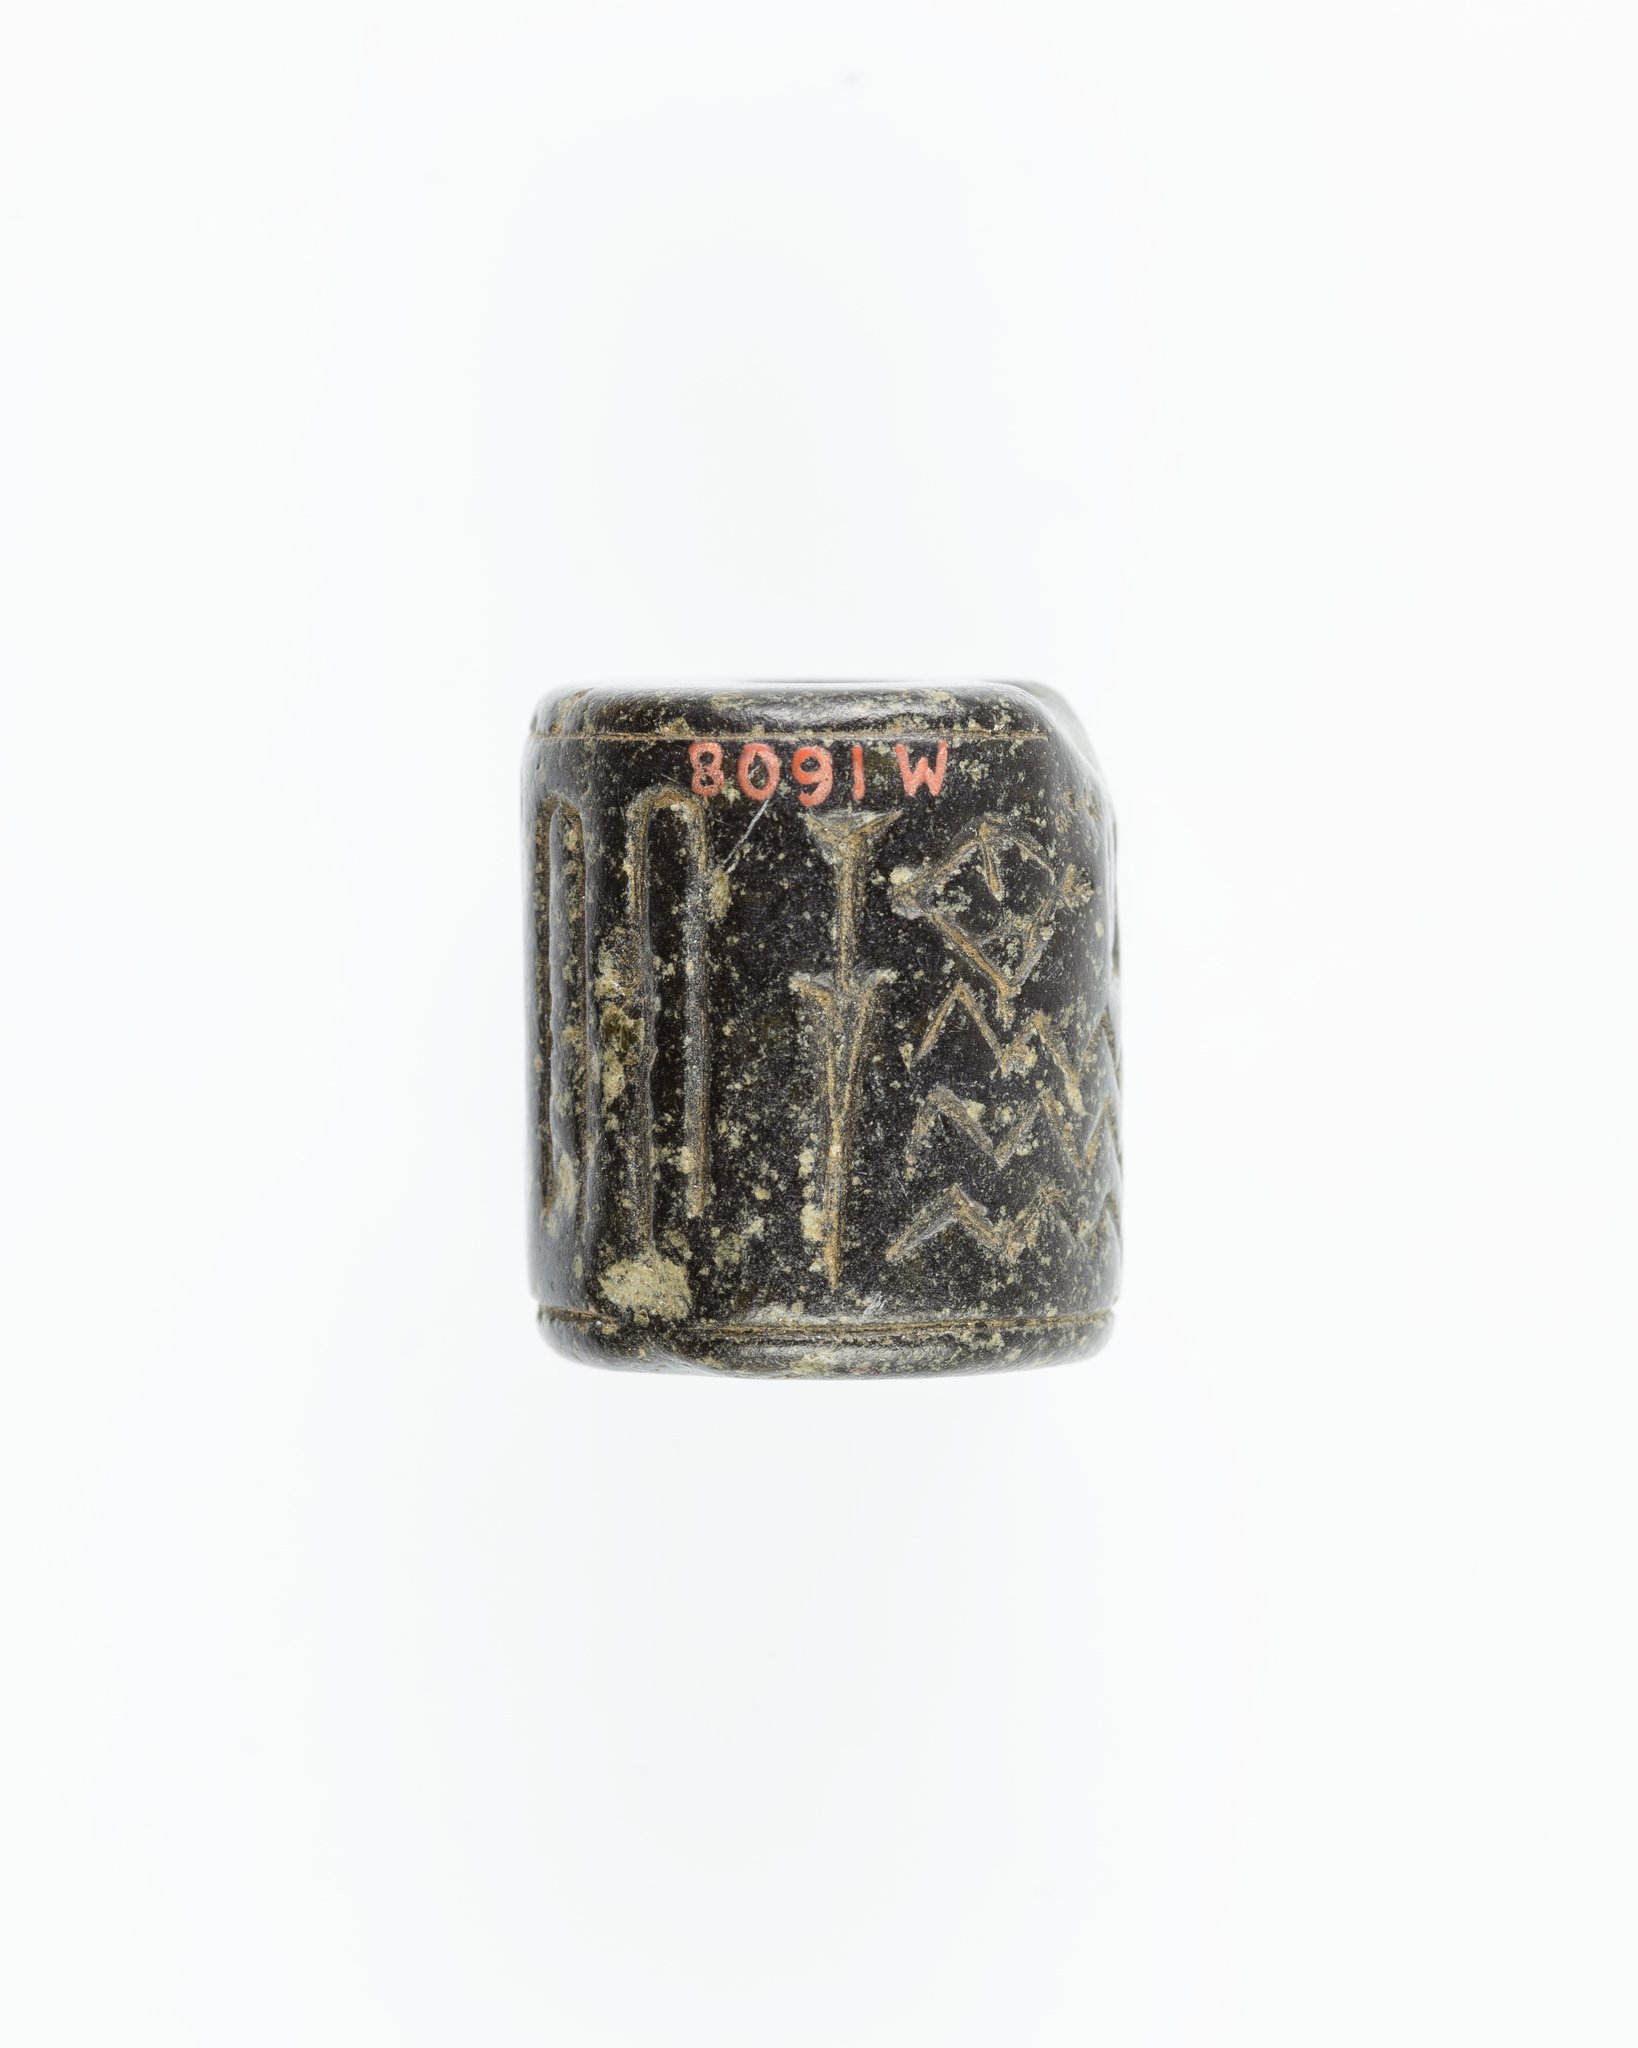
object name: cylinder seal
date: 2960-2649 BCE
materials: stone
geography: egypt